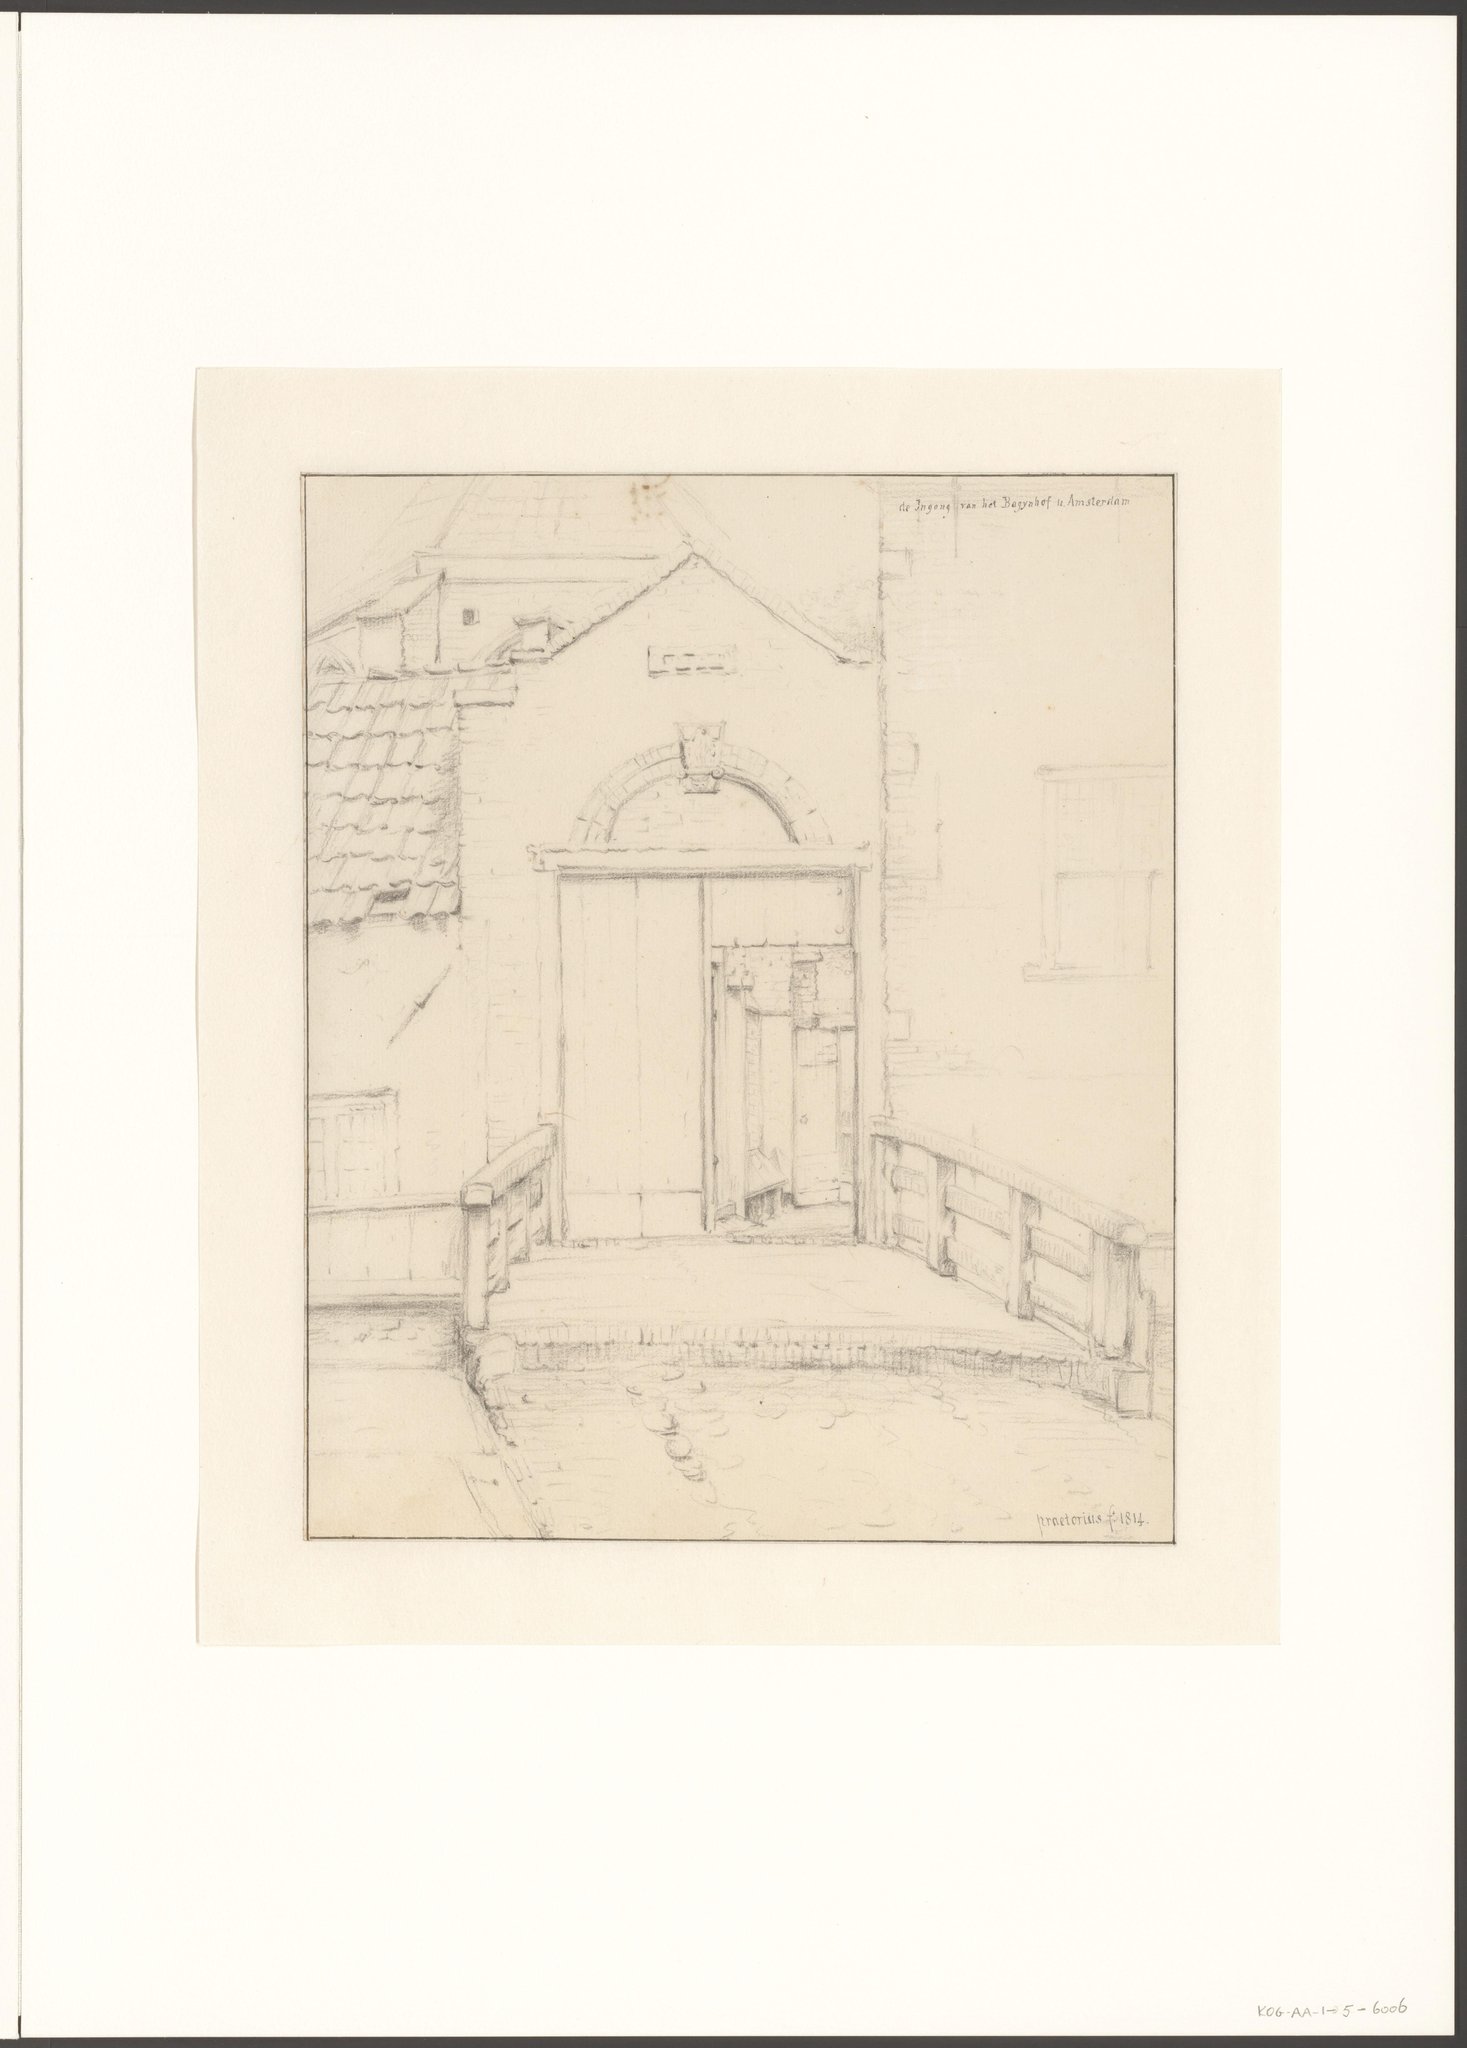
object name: drawing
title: Gezicht op de ingang van het Begijnhof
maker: pieter ernst hendrik praetorius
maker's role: draughtsman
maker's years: 1791-1876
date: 1814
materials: chalk, paper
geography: amsterdam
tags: alms-house (dutch: 'hofje'), city-view in general; 'veduta', gate, entrance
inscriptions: inscription: ‘de Ingang van het Bagynhof te Amsterdam’, signature and date: ‘praetorius ft 1814.’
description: Onderwerpsrubriek binnen de Atlas Amsterdam: Begijnensloot (Gedempte), Bagijnhofsteeg, Beulingsloot, Bickersgracht en –plein, Bickersstraat (Groote), Bilderdijkskade en -straat, Binnenkant, Blauwburgwal, Boomdwarsstraat, Brouwersgracht, Bleekersspad (Lange), Bleekerssloot, Bloemgracht, Boerenwetering, Boltensgrachtje, Boomssloot (Recht), Badhuisweg.